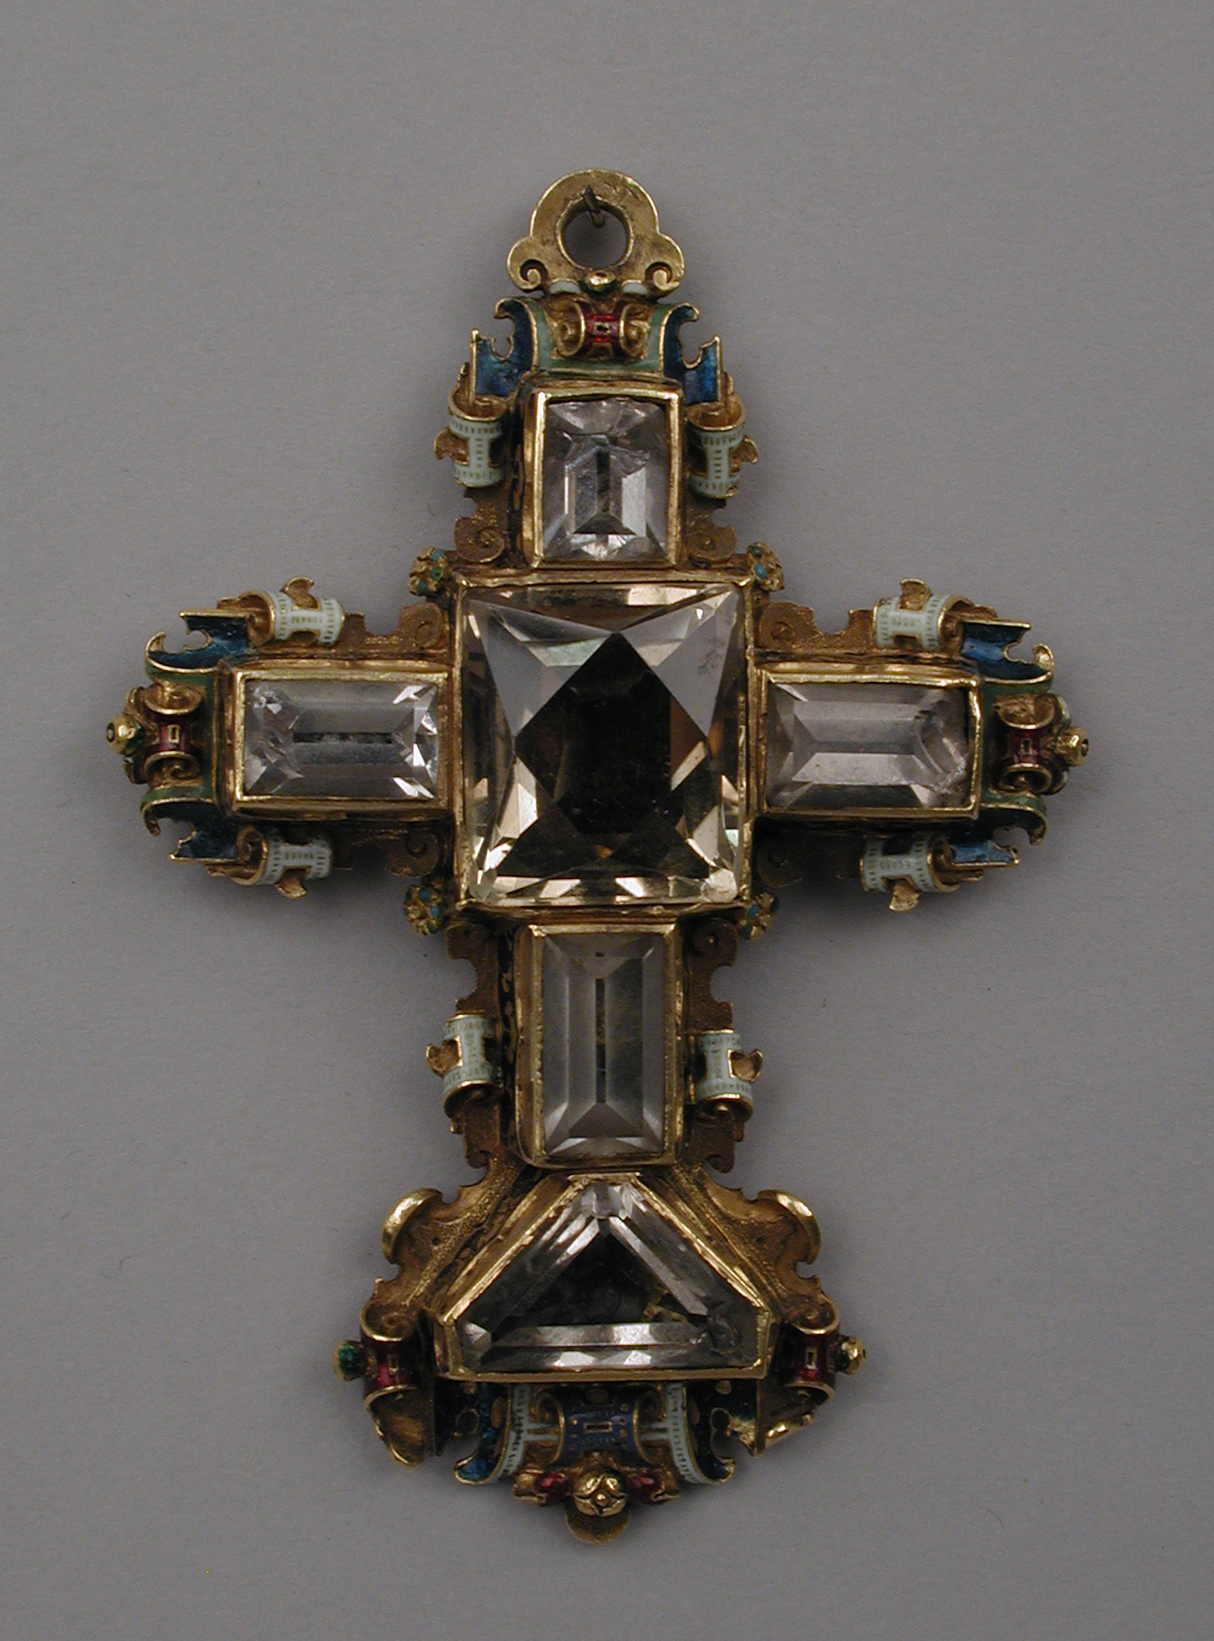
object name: reliquary cross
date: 1586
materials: gold, quartz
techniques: enamel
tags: cross,reliquaries